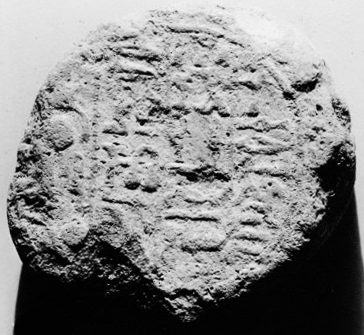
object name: cone, user, scribe, overseer of field, cornmeasurer of amun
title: Funerary Cone of the Scribe User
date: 1479-1425 BCE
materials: pottery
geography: egypt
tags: hieroglyphs